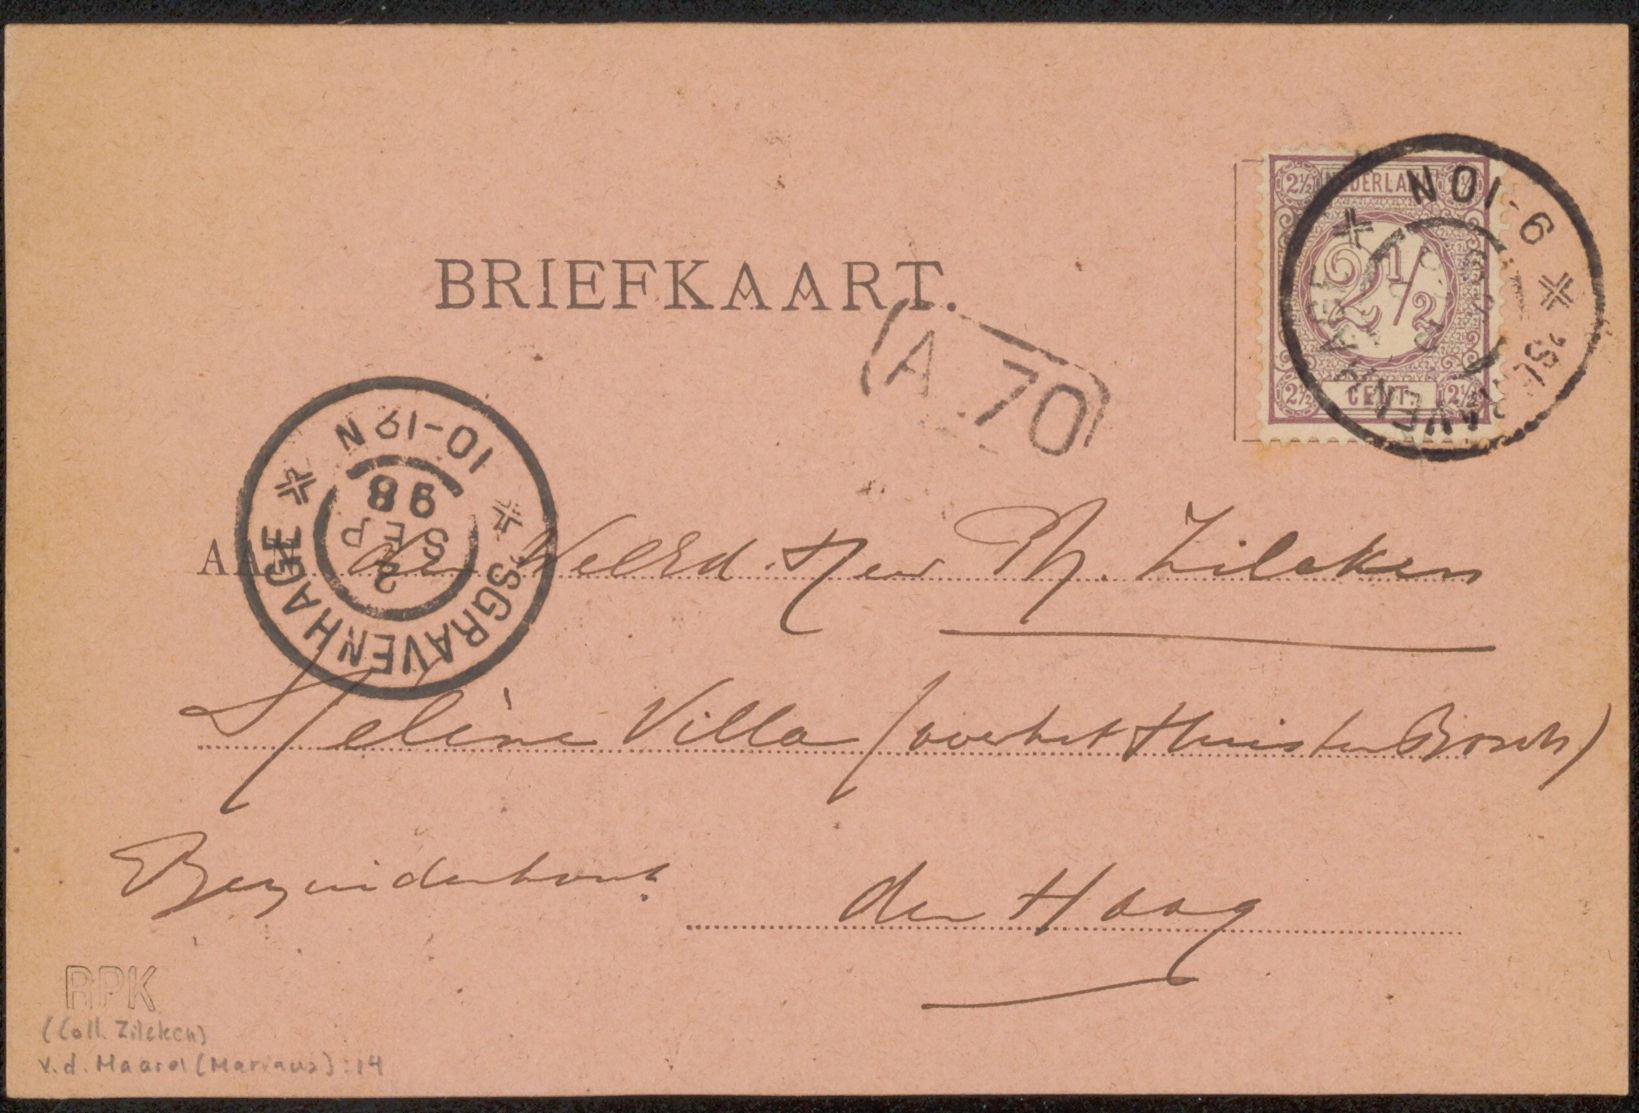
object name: postcard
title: Briefkaart aan Philip Zilcken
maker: marinus van der maarel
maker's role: draughtsman, painter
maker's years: 1857-1921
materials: cardboard, ink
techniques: pen, writing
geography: the hague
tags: philip zilcken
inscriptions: collector's mark: ‘RPK’